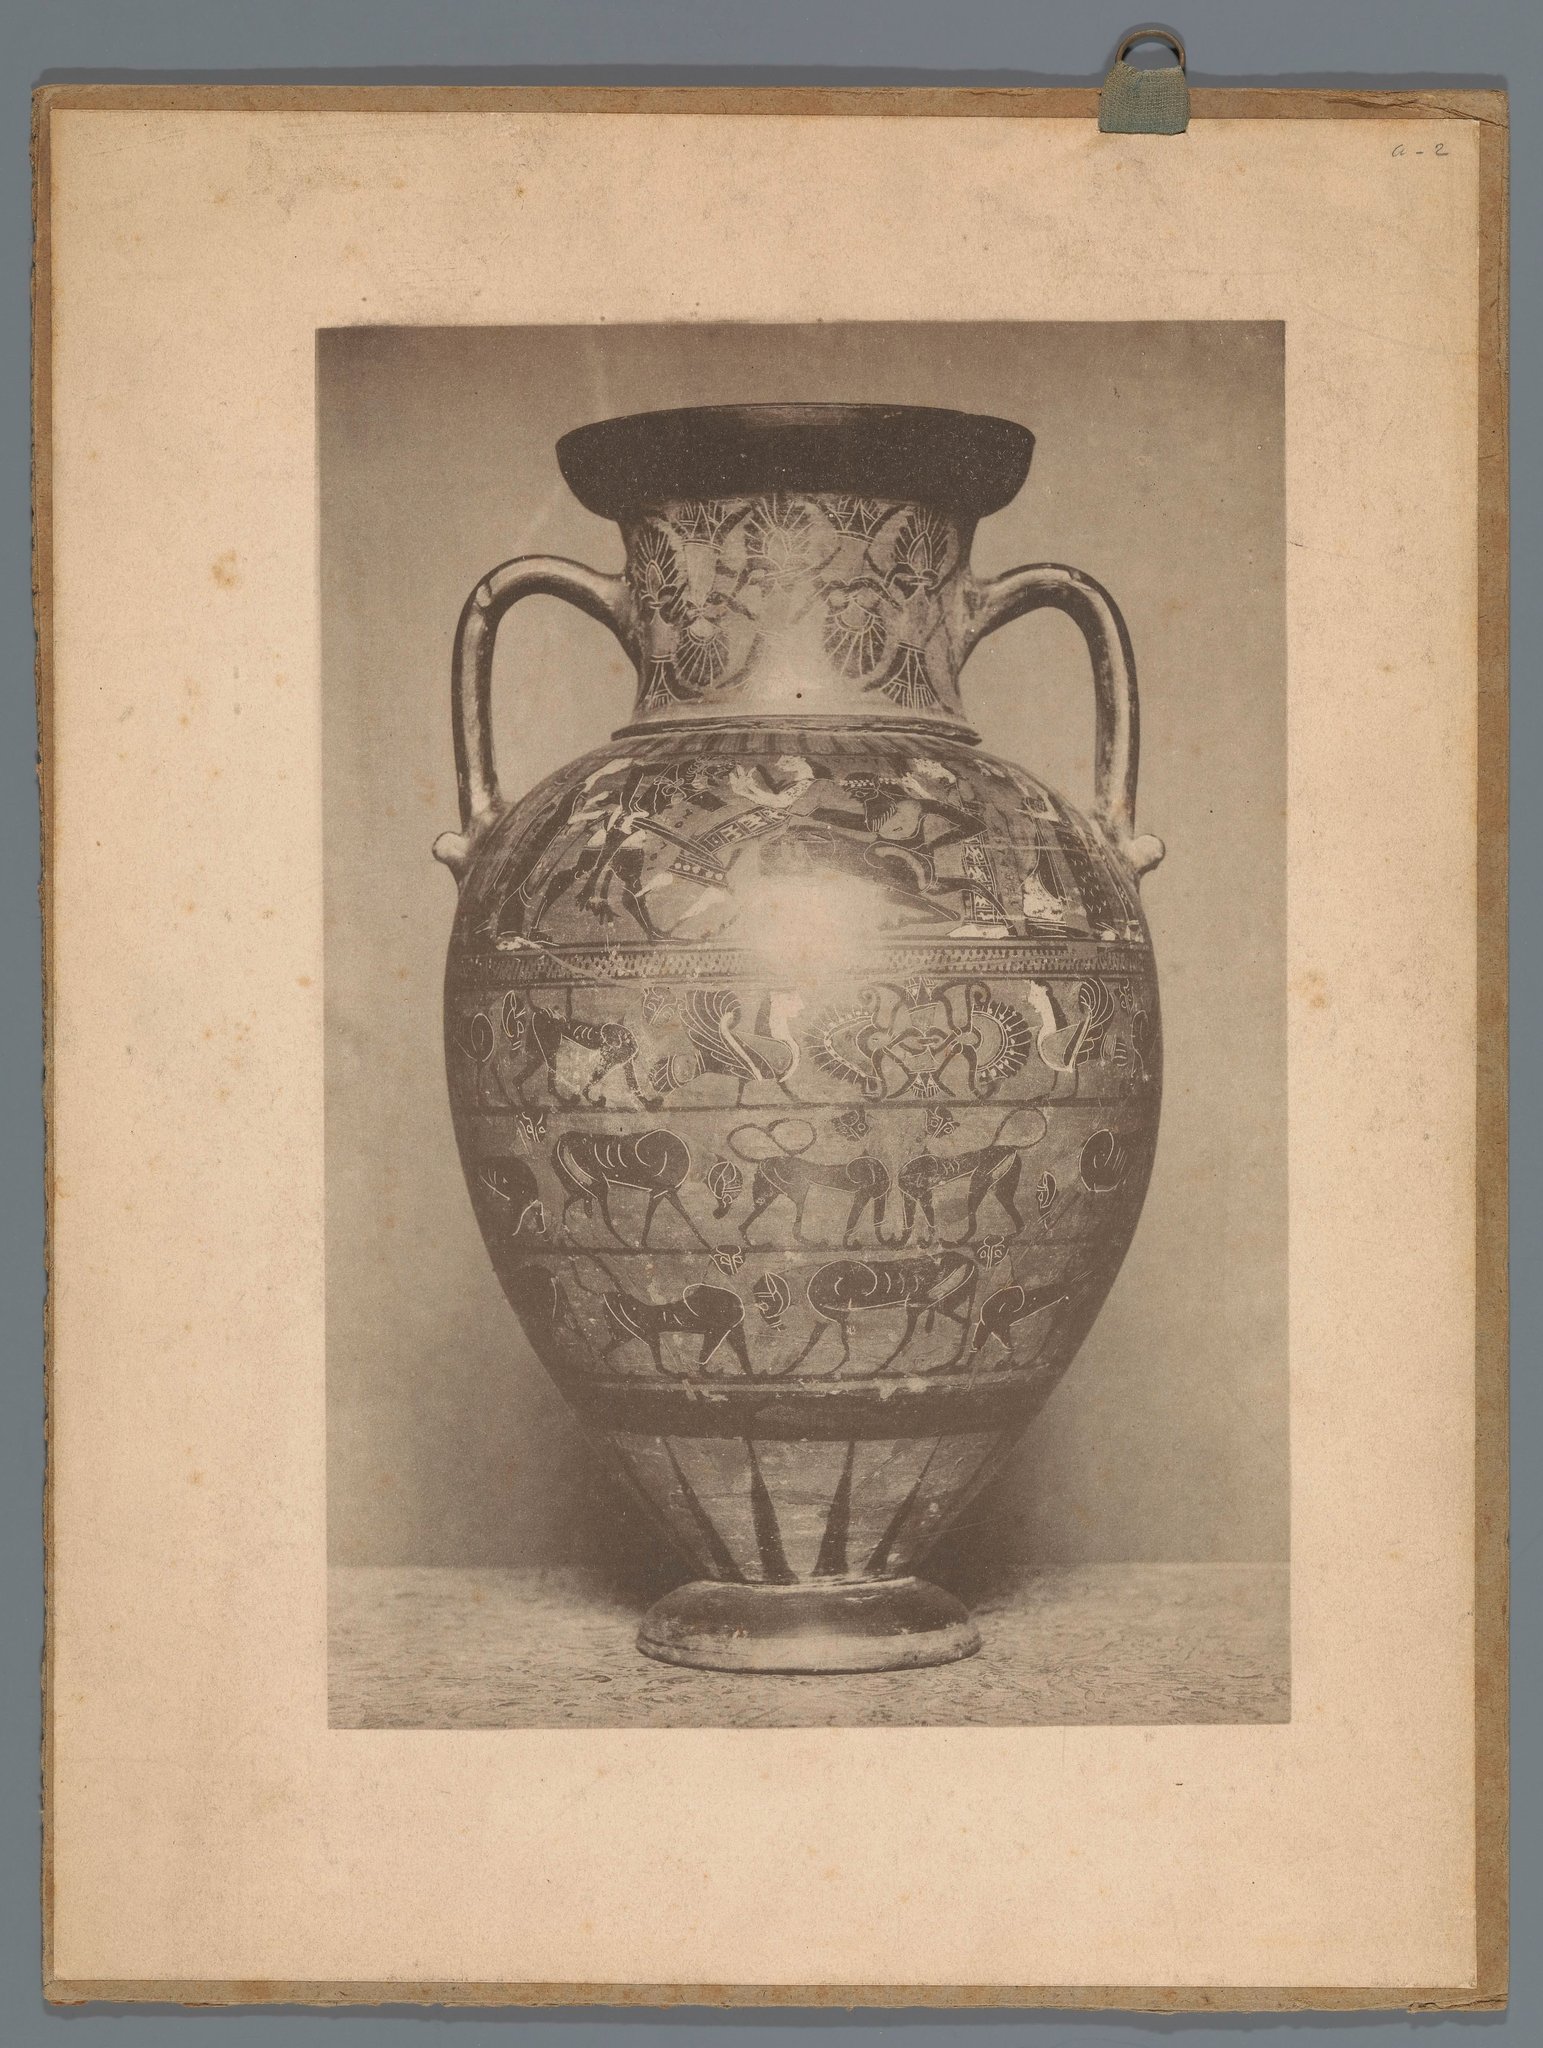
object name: photograph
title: Etruskische vaas gedecoreerd met dieren en mensen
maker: Anonymous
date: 1875-1900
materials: cardboard, linen, metal, paper, ink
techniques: photograph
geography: europe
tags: ornament ~ hybrid animals, container of stone: stone vase, italy